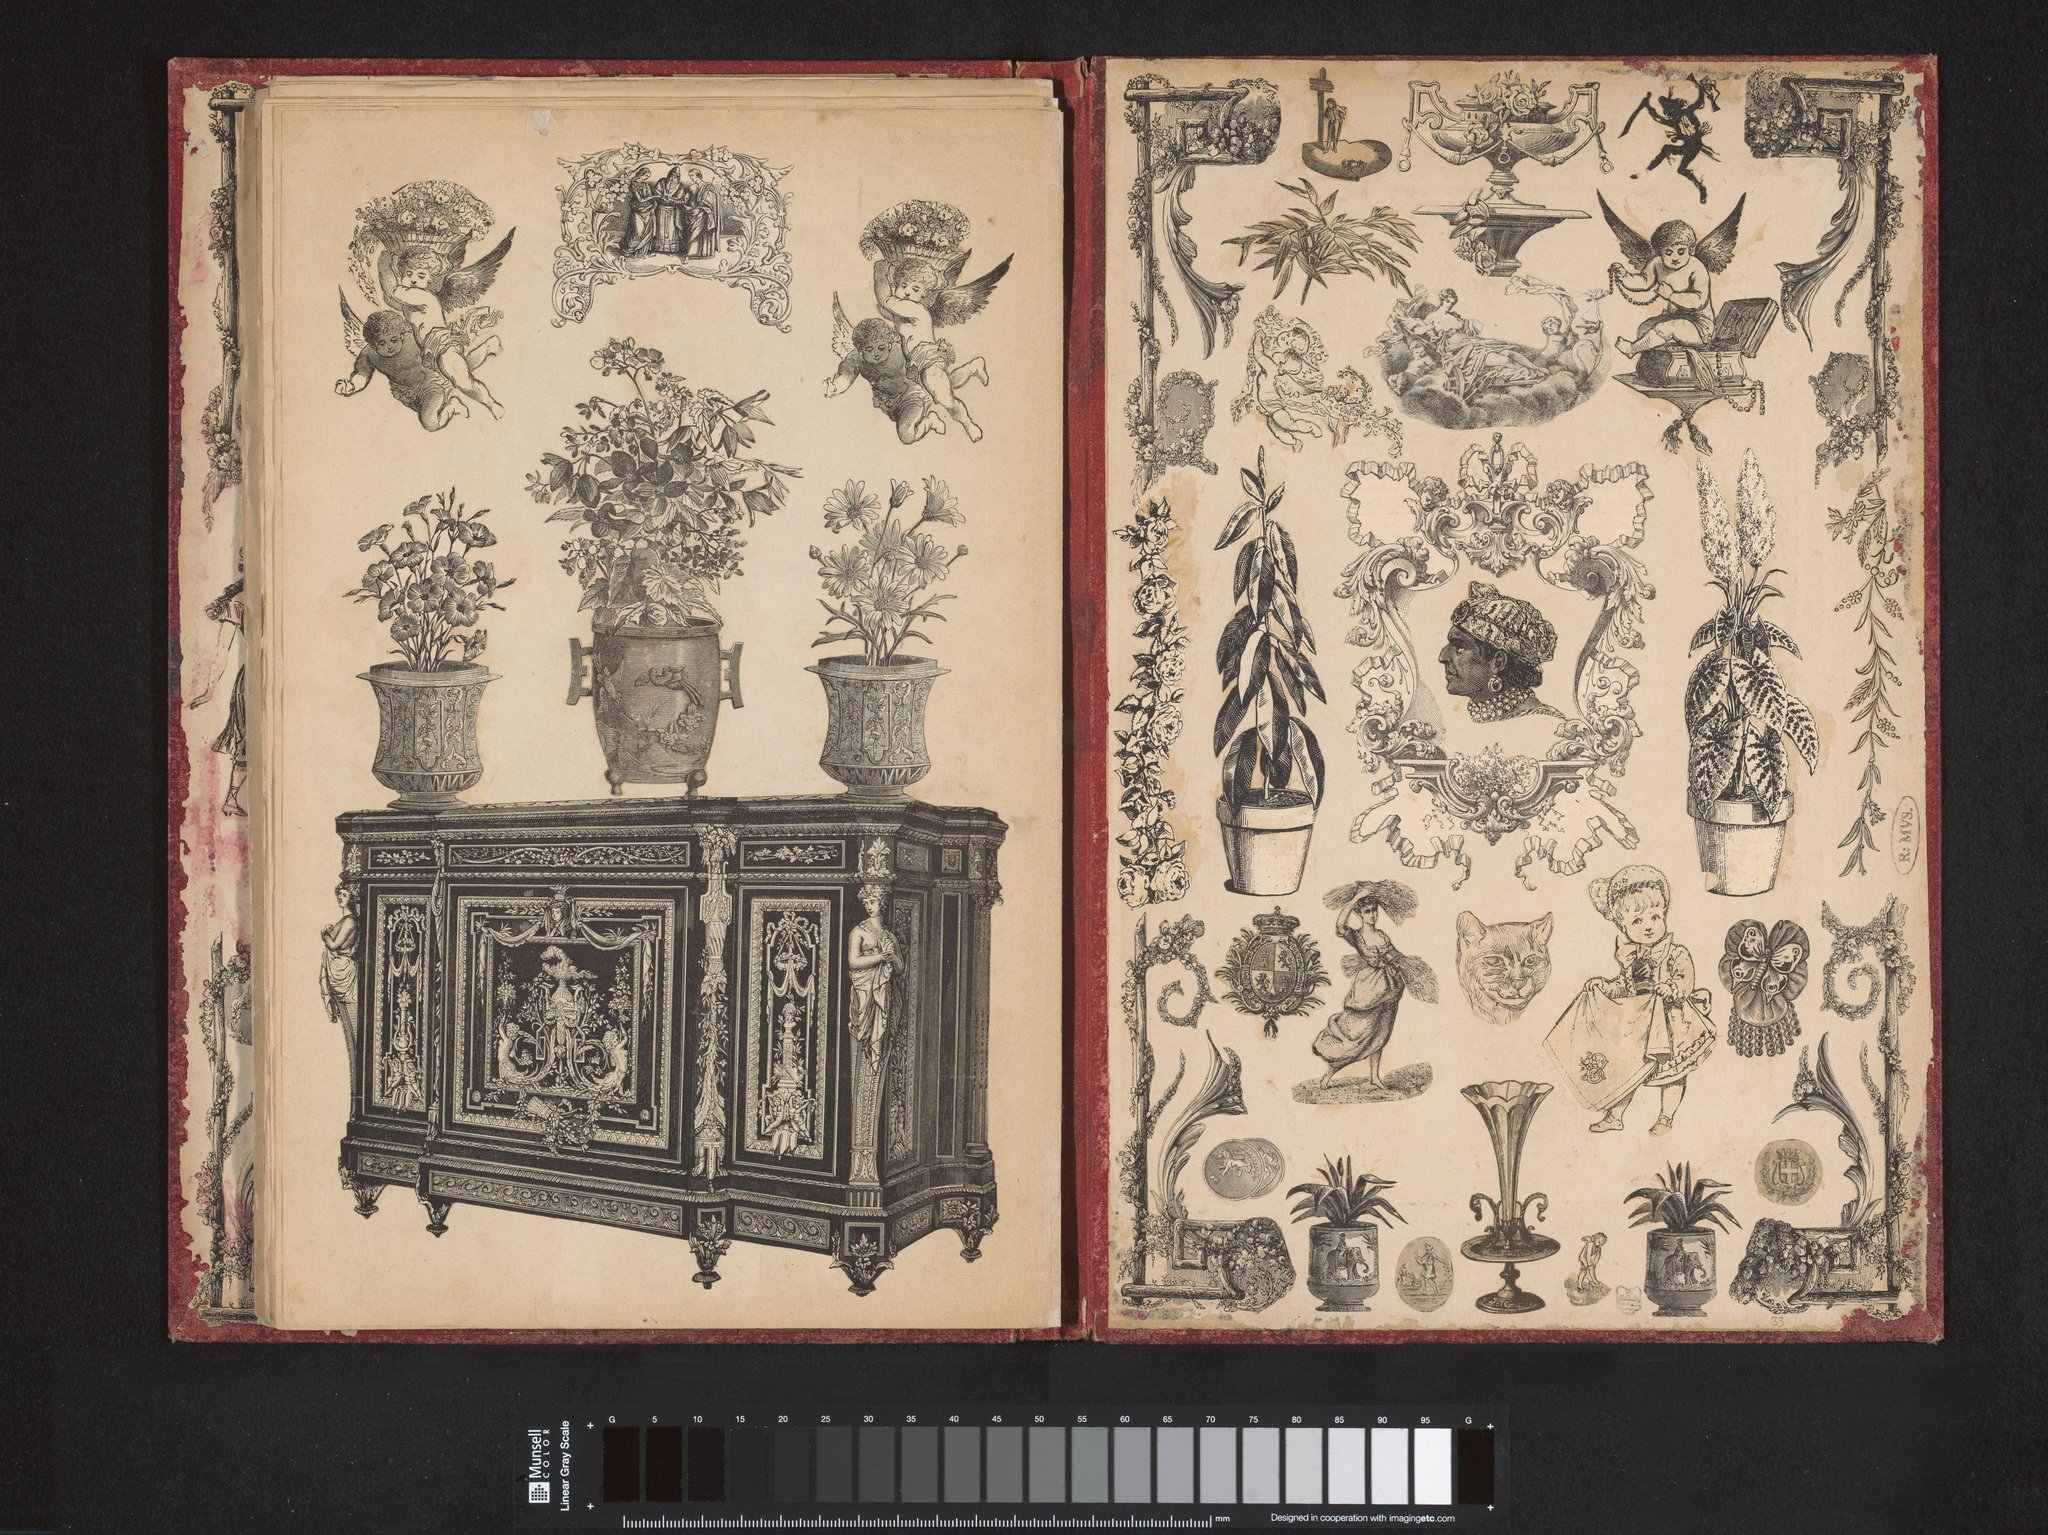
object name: endleaf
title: Collage van uitgeknipte prenten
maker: Anonymous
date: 1870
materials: paper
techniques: engraving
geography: paris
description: Collage van uitgeknipte prenten geplakt op het achterste schutblad. Onderdeel van een album met 32 bladen, aan beide zijden beplakt met uitgeknipte prenten, vermoedelijk afkomstig uit 19e-eeuwse tijdschiften.